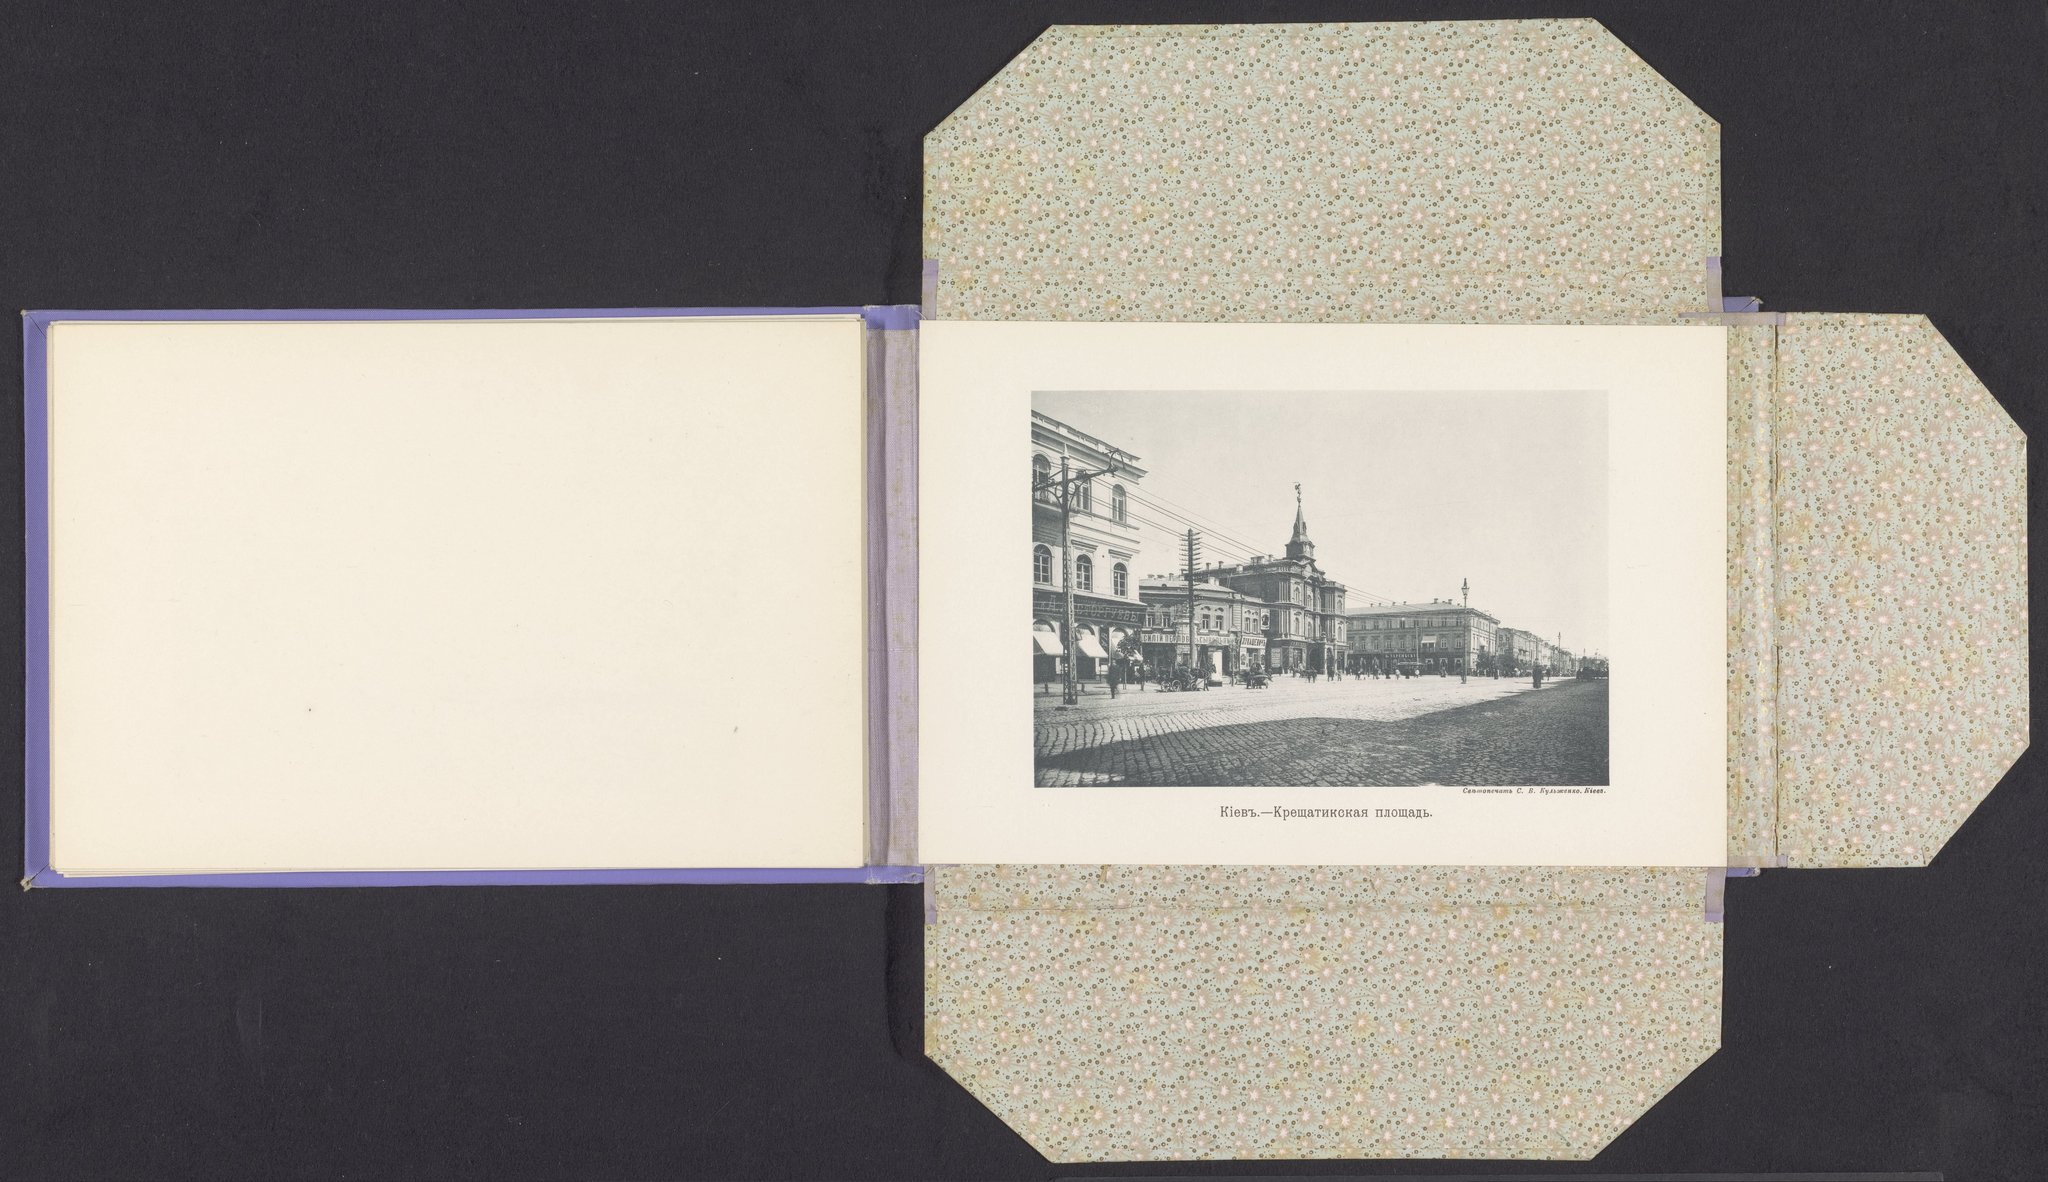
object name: page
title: Kieвъ.- Kрeщaтикcкaя плoщaдь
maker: Anonymous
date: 1886-1896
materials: paper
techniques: photograph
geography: khreshchatyk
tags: square, place, circus, etc., street